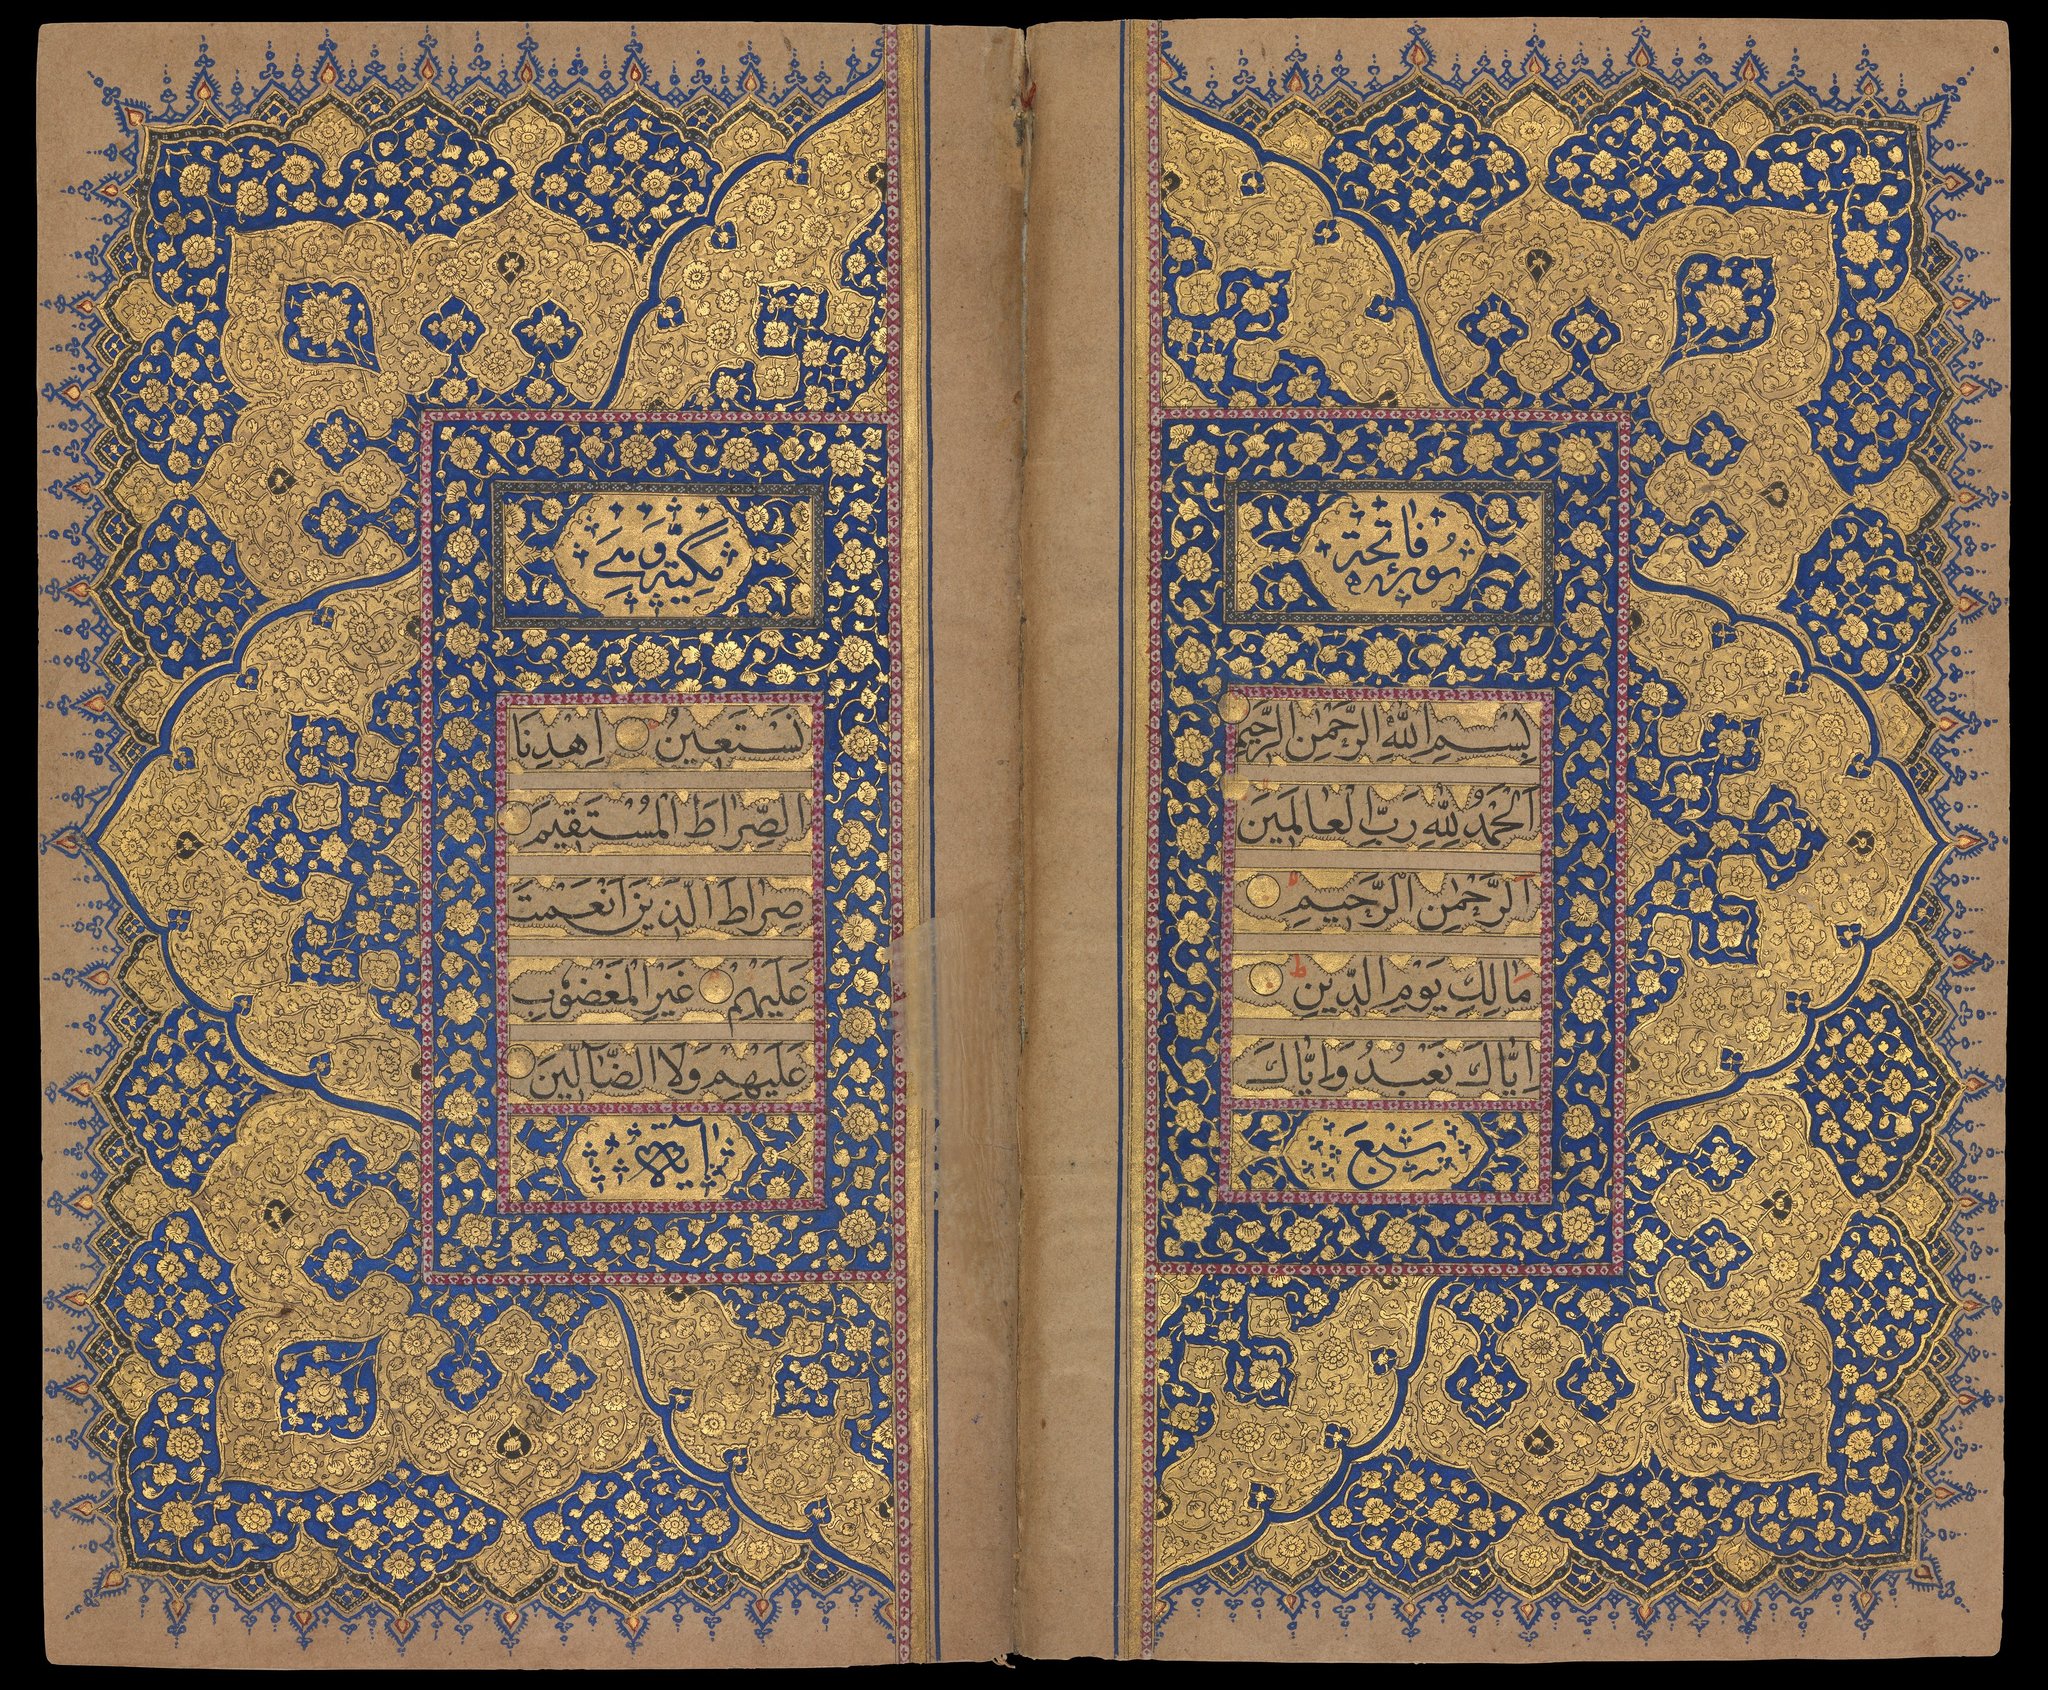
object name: non illustrated manuscript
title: Qur'an Manuscript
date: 1767-1833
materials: gold, ink, leather, paper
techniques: bookbinding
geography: india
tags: qur'an,calligraphy